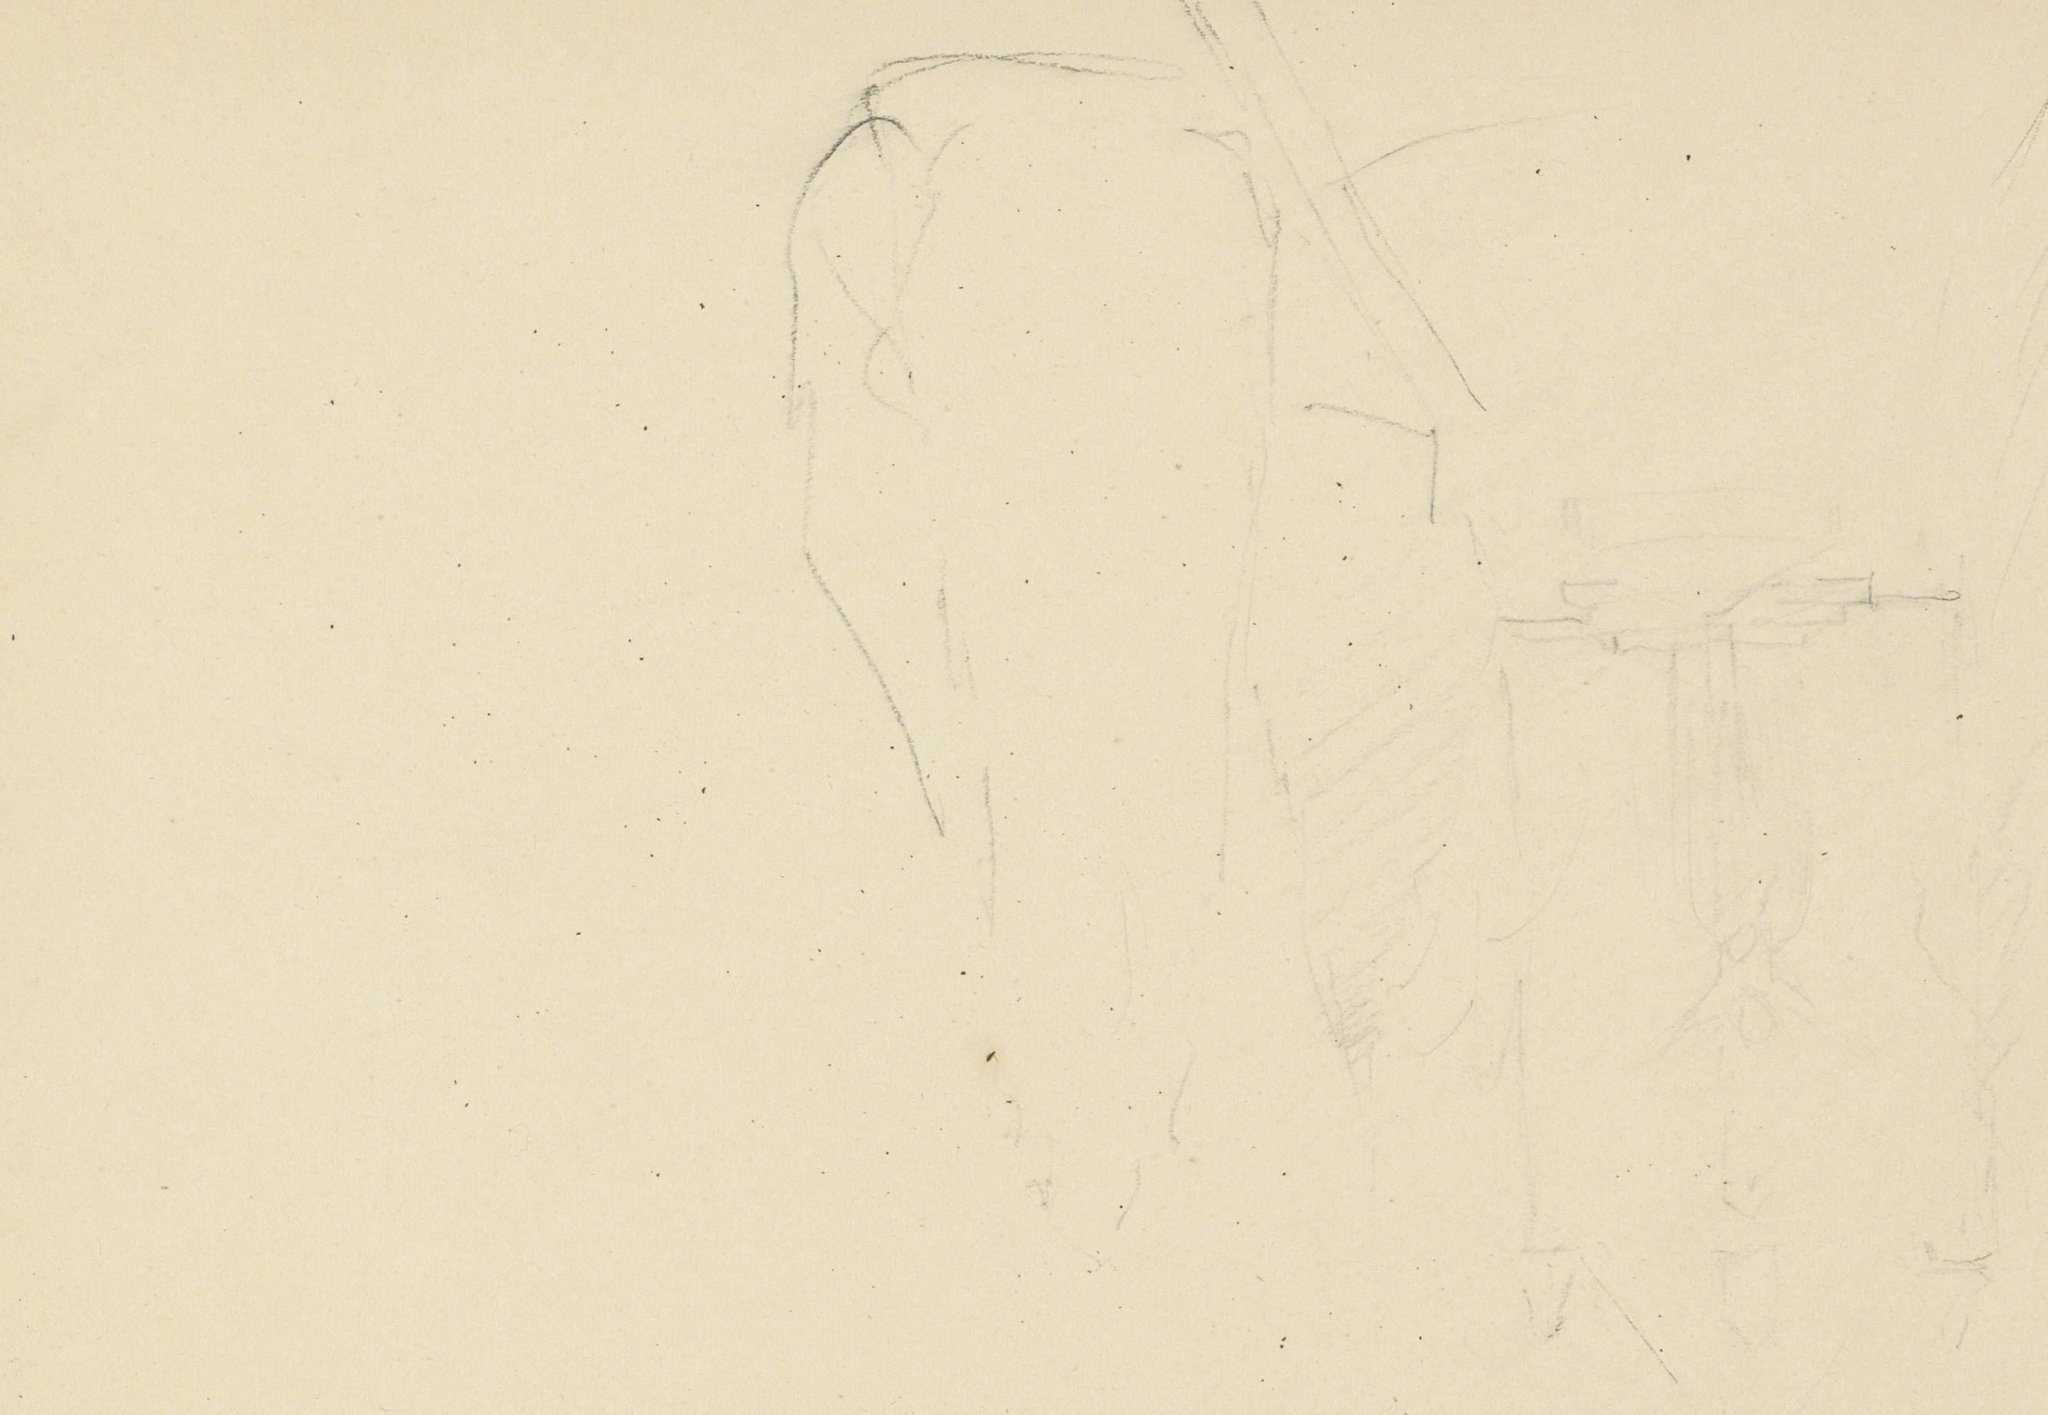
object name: sketchbook leaf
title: Pad richting een gebouw met torens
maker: antoon derkinderen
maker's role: draughtsman, painter, print maker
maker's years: 1859-1925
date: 1869-1925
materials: paper, pencil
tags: road, path, tower (of house or building)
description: Langs het pad figuren of bomen. Blad 8 verso uit een schetsboek met 28 bladen.